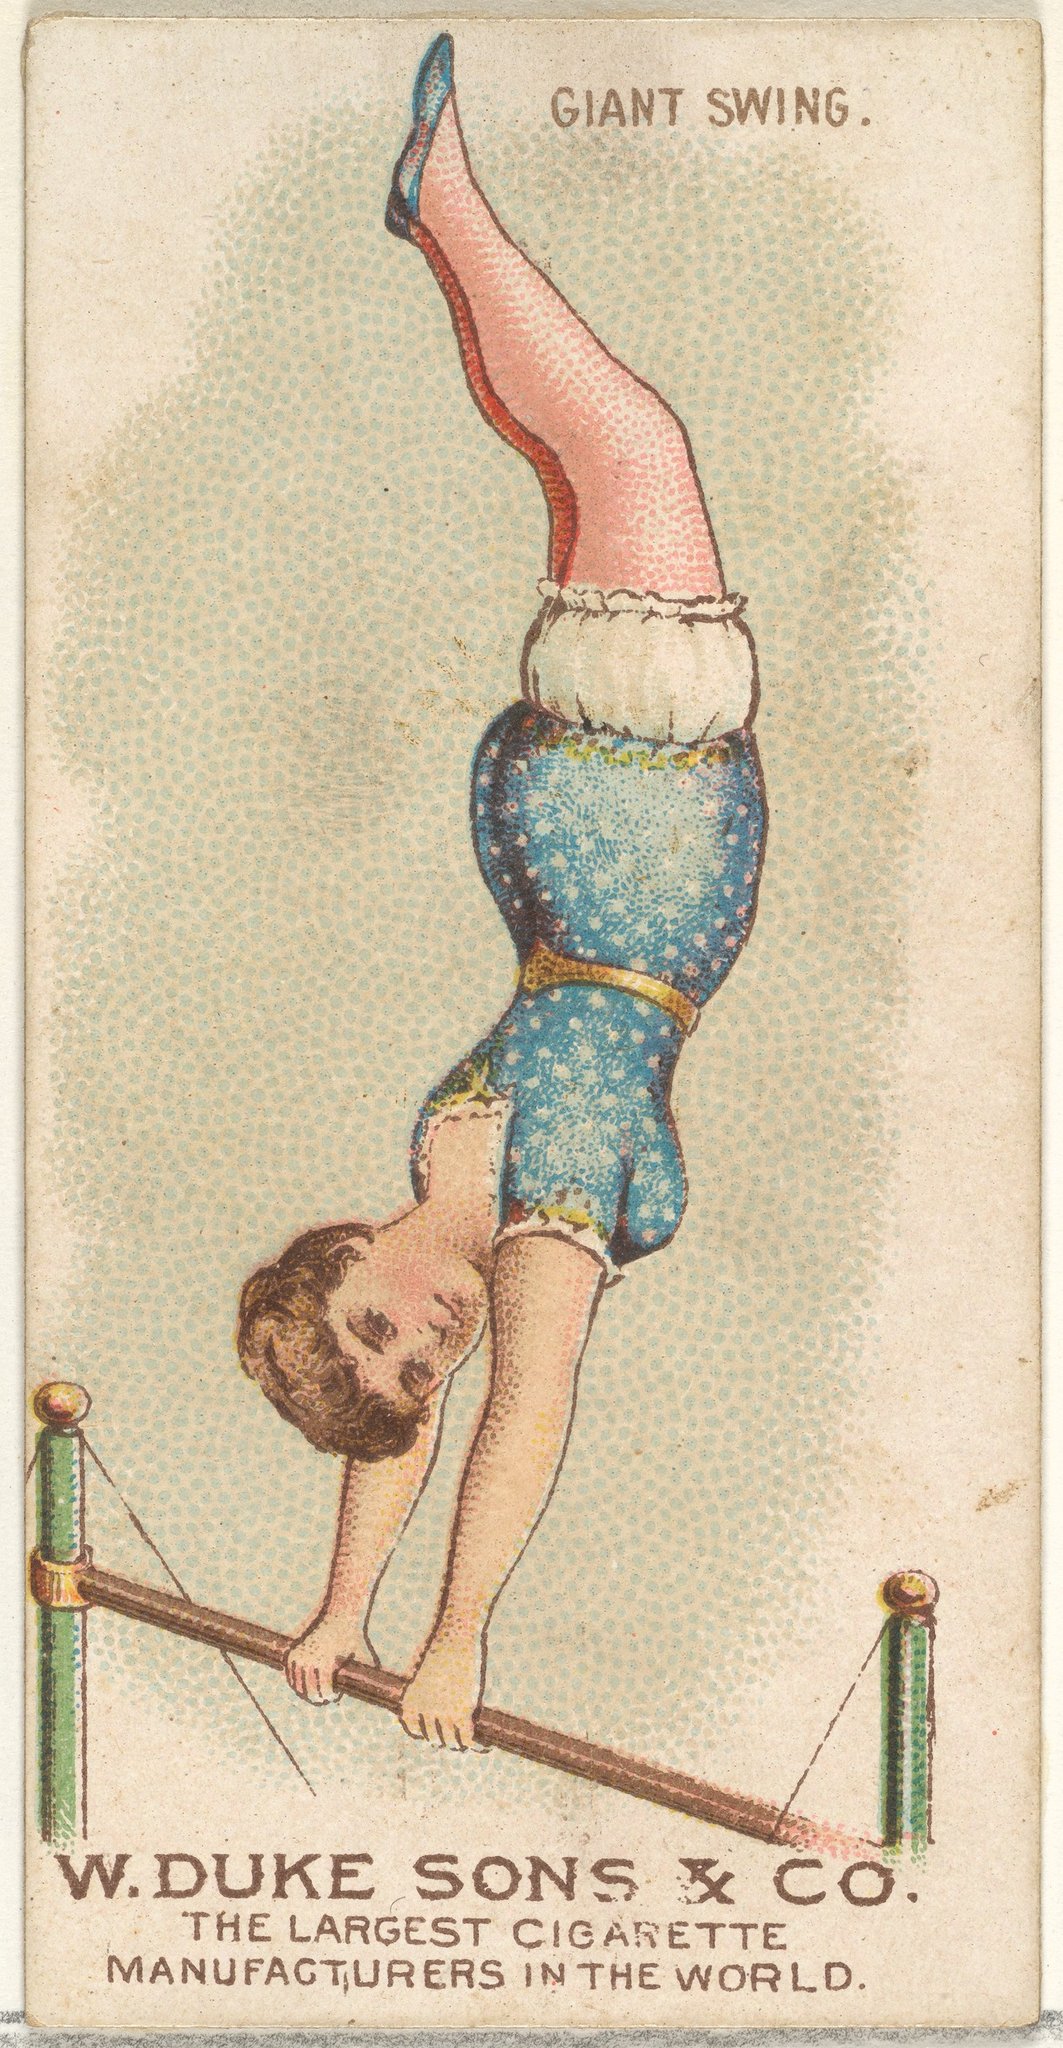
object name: print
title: Giant Swing, from the Gymnastic Exercises series (N77) for Duke brand cigarettes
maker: w. duke, sons & co.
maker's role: publisher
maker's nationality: american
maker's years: 1870-1920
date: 1887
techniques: color lithograph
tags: women,athletes